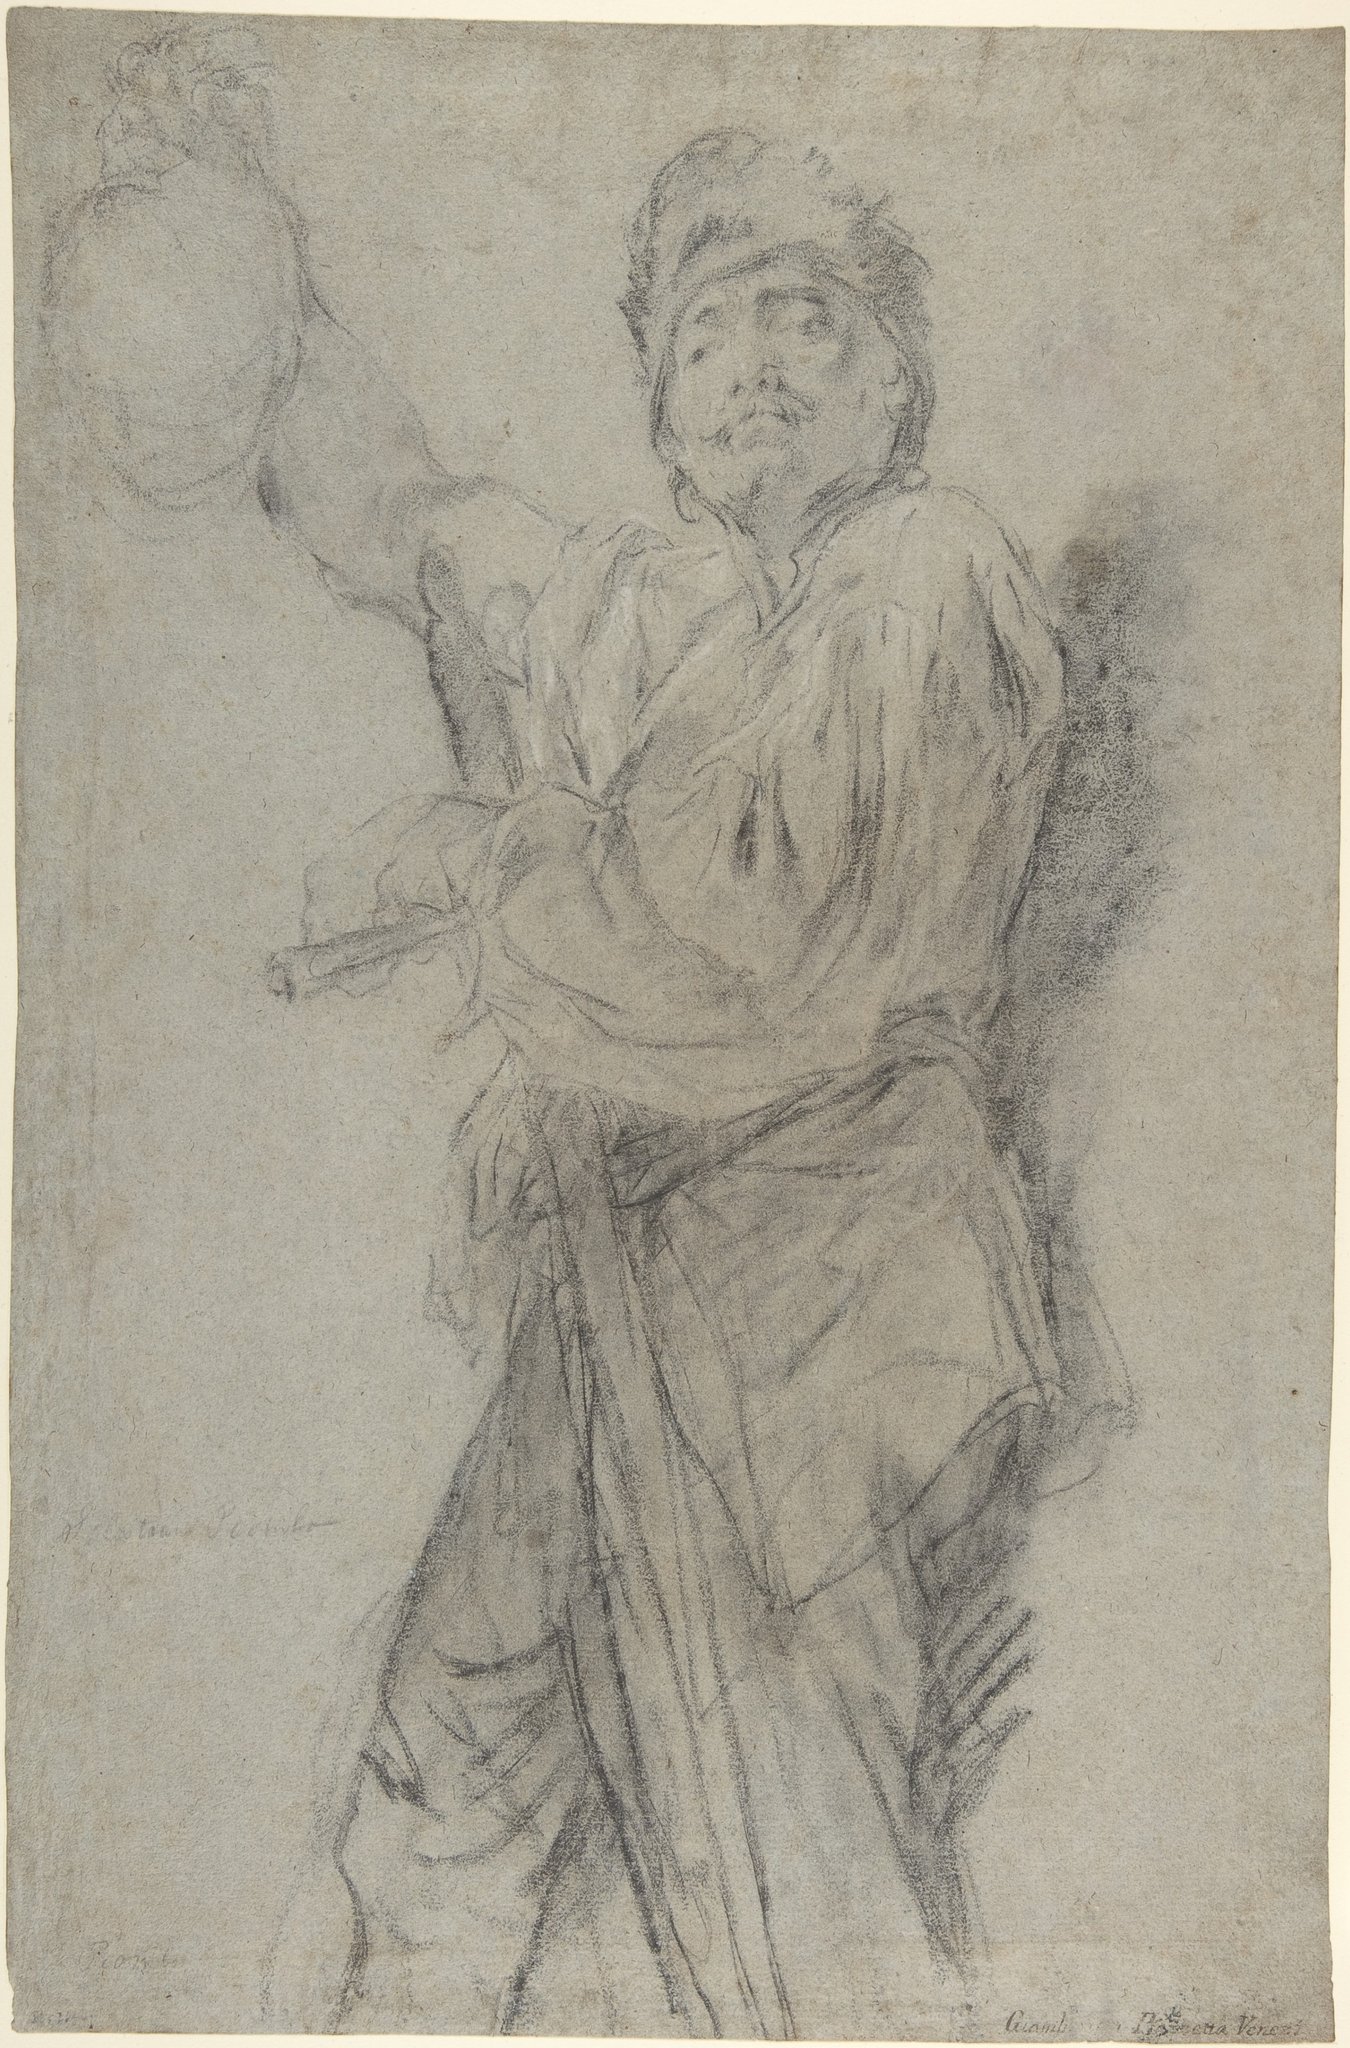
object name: drawing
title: Executioner Holding Up a Severed Head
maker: giovanni battista piazzetta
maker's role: artist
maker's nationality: italian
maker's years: 1682-1754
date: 1682-1754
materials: chalk, charcoal, paper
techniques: highlighting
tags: swords,heads,men